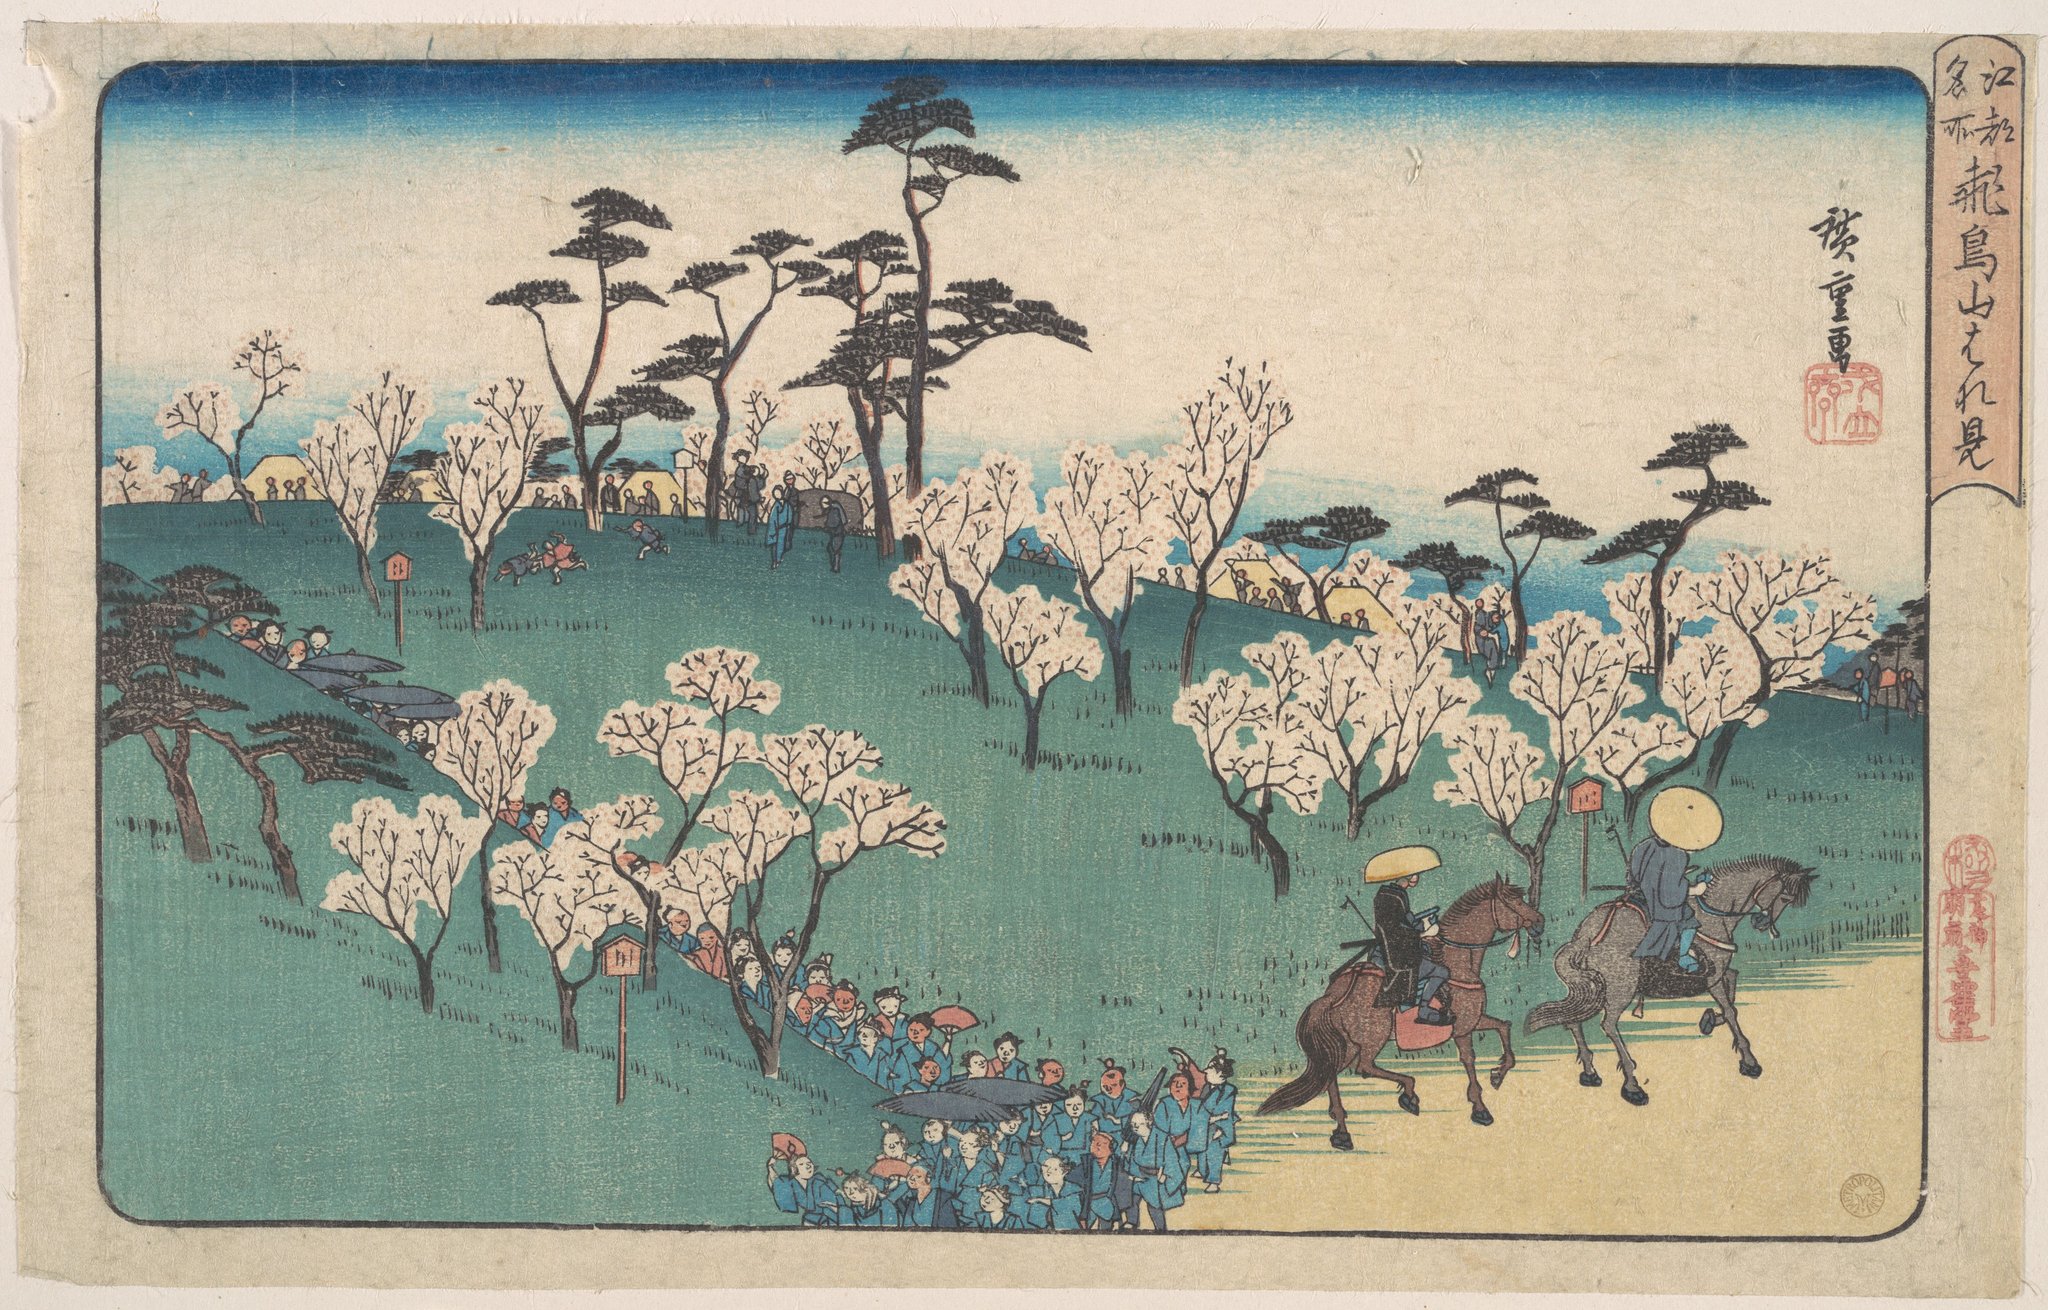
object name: print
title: Asakayama Hanami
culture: japanese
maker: utagawa hiroshige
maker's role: artist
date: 1834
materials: ink, paper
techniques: woodblock print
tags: human figures,horses,trees,crowd